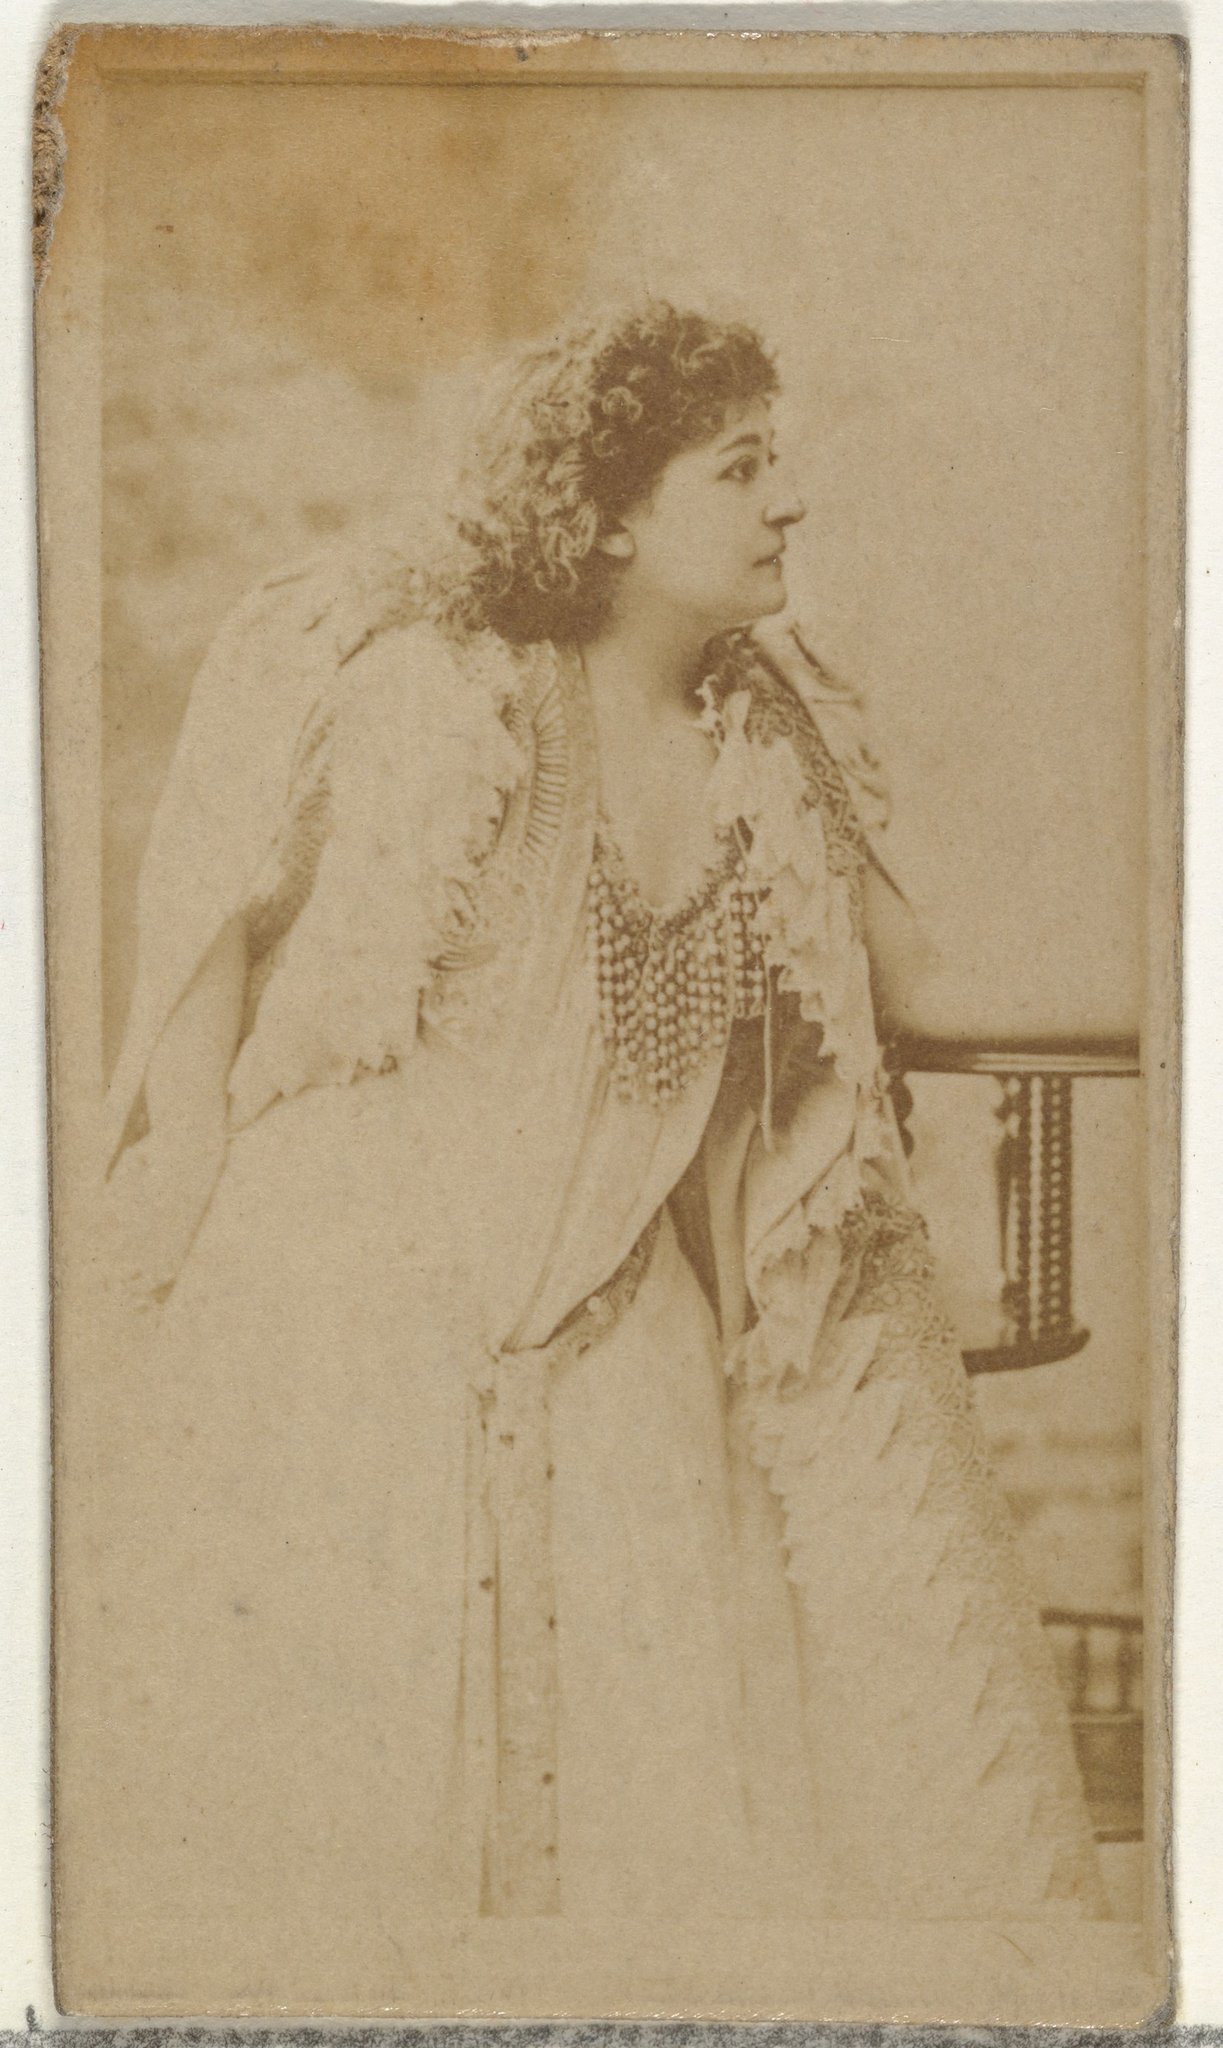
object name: photograph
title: [Actress posing in thick cloak], from the Actors and Actresses series (N145-8) issued by Duke Sons & Co. to promote Duke Cigarettes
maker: w. duke, sons & co.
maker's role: publisher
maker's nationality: american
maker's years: 1870-1920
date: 1891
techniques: albumen silver print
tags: women,actresses